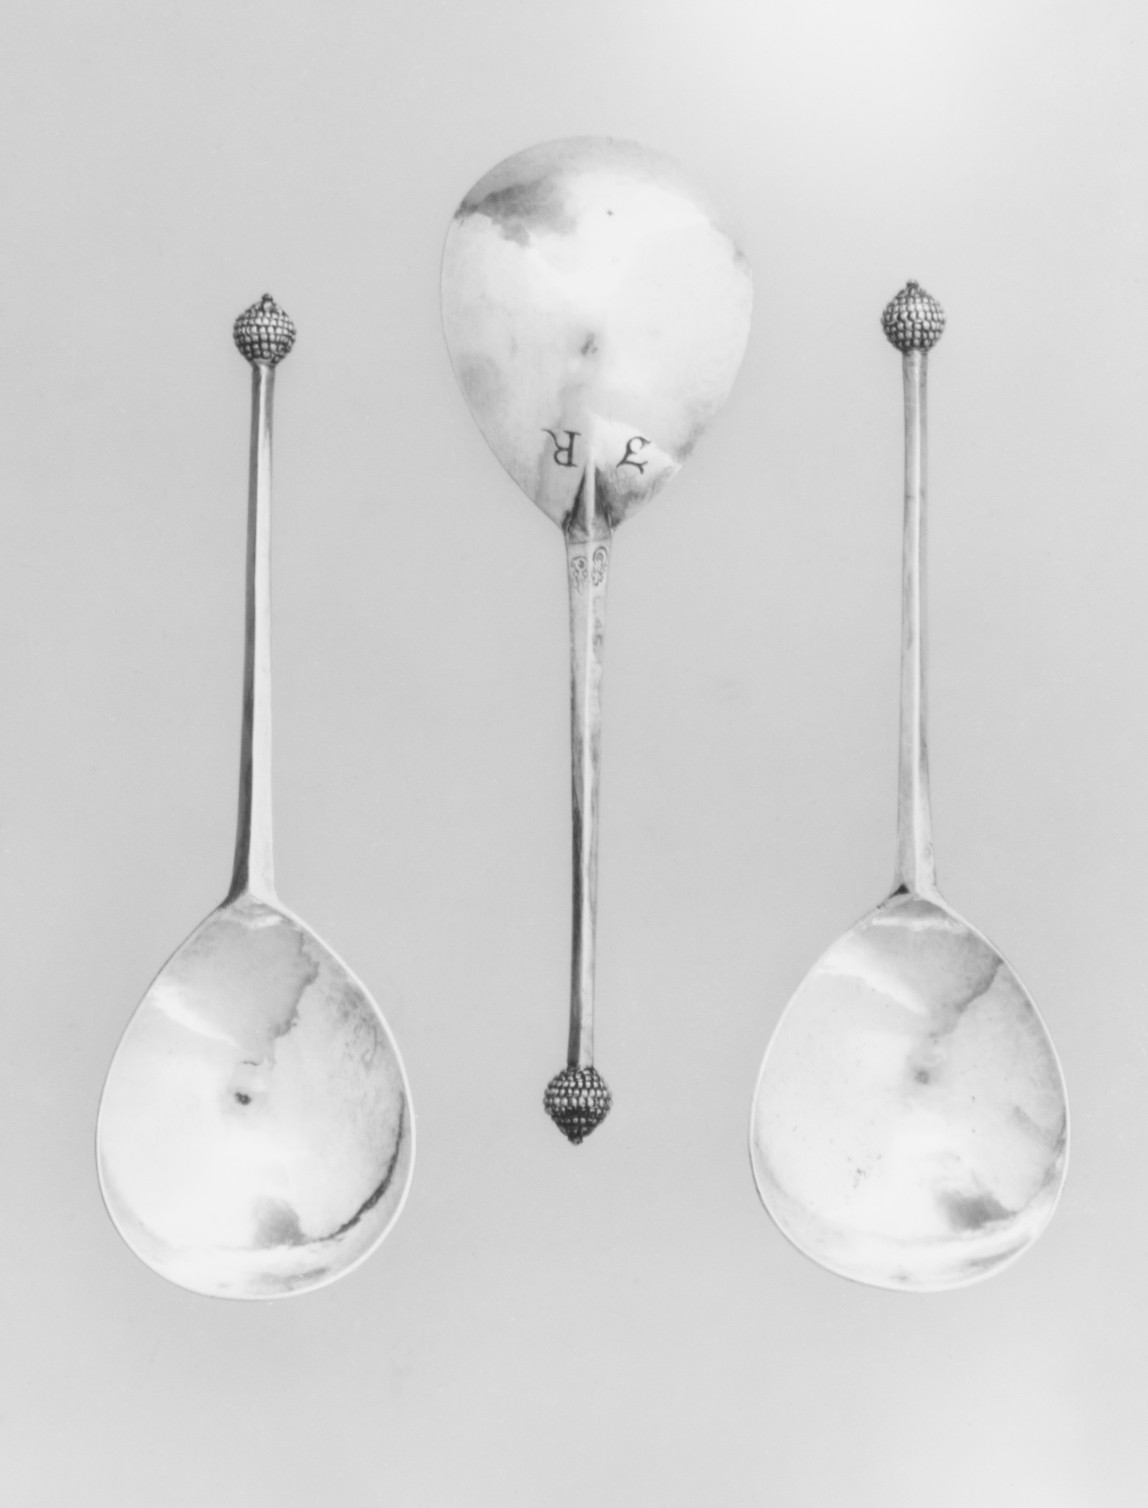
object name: spoon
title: Set of six spoons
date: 1801-1900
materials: gilt, silver